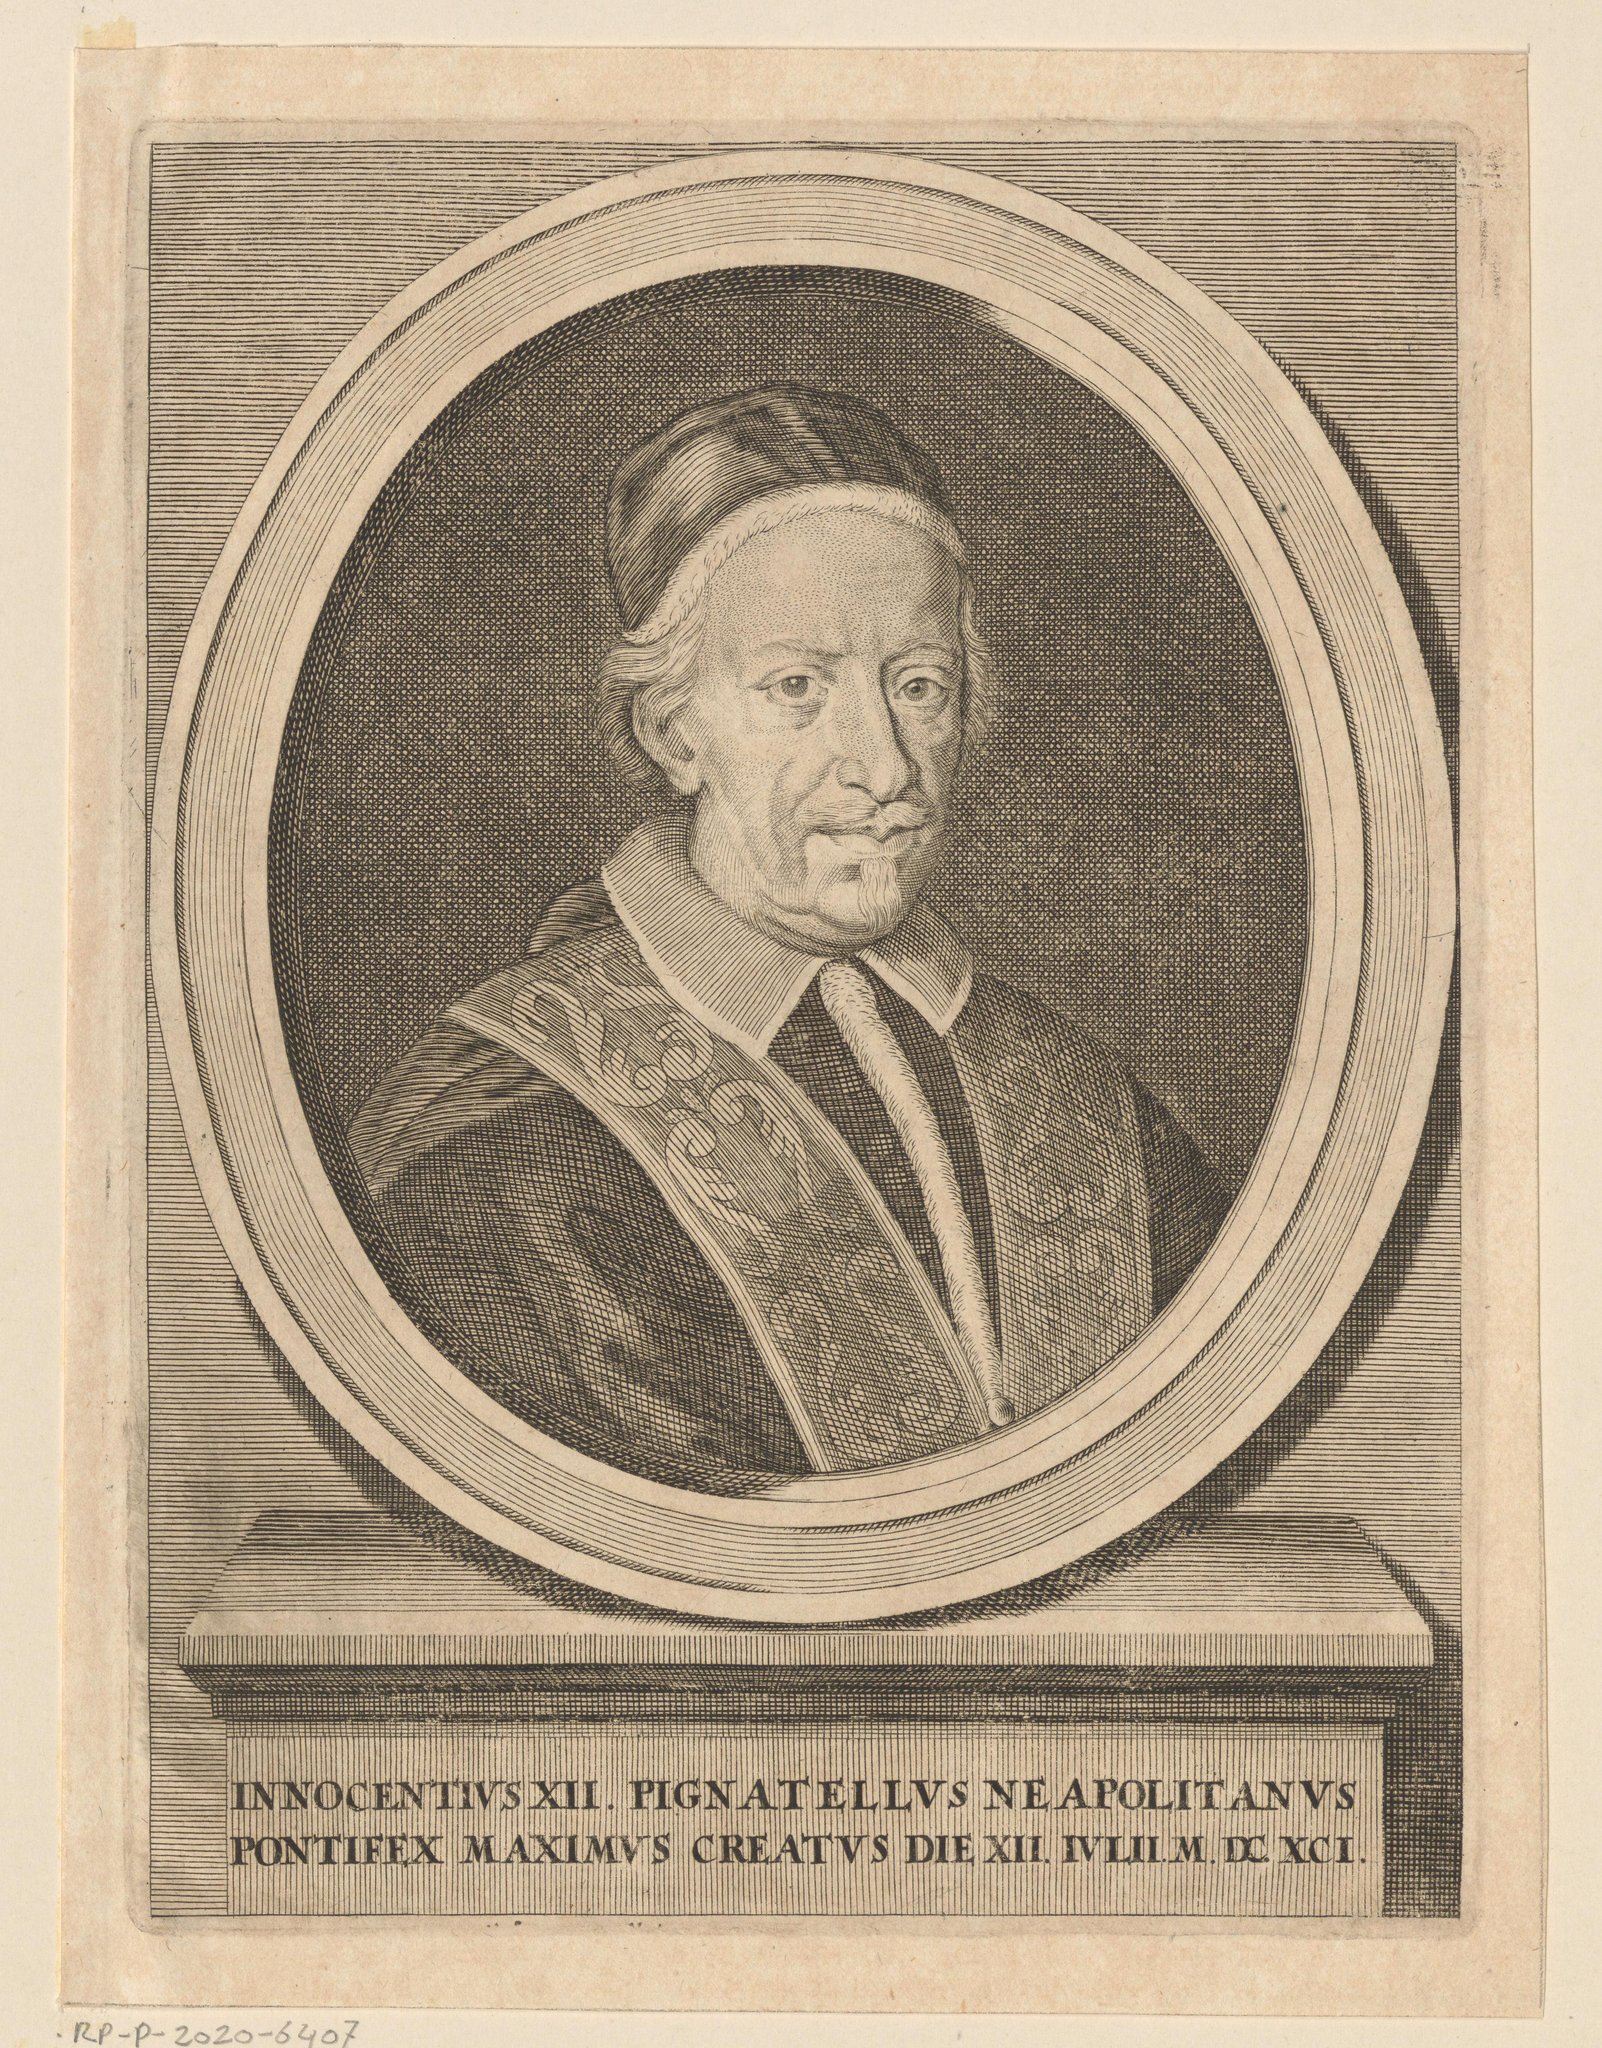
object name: print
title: Portret van paus Innocentius XII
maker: Anonymous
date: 1707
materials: paper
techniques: engraving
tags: naples, rome, clergyman, innocentius xii, historical persons, pope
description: Prent mogelijk uit: Theatrum Europaeum (...). Frankfurt: erven Carl Gustav Merian, 1707, dl. 15.